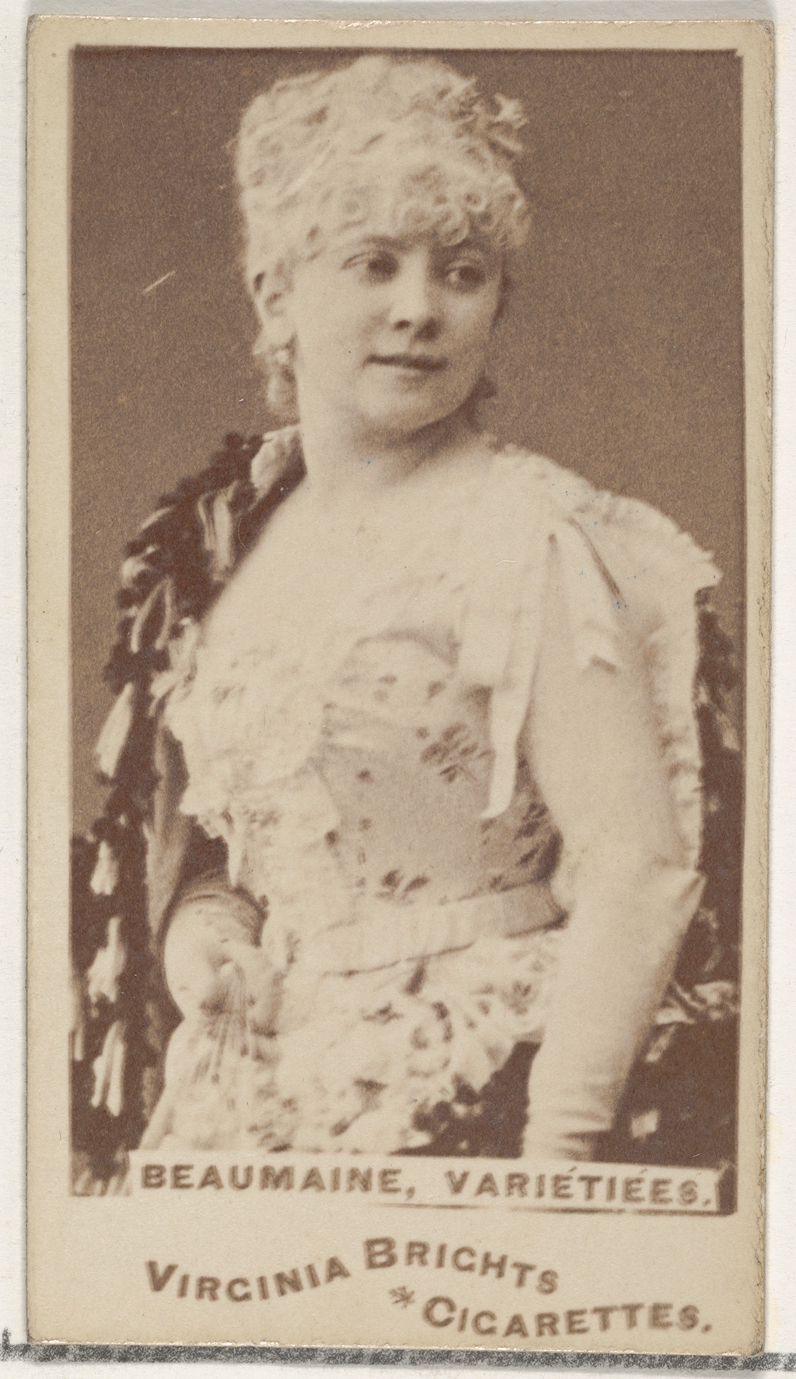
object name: photograph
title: Beaumaine, Varietiees, from the Actors and Actresses series (N45, Type 1) for Virginia Brights Cigarettes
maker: allen & ginter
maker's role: publisher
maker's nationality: american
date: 1888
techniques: albumen silver print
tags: portraits,women,actresses